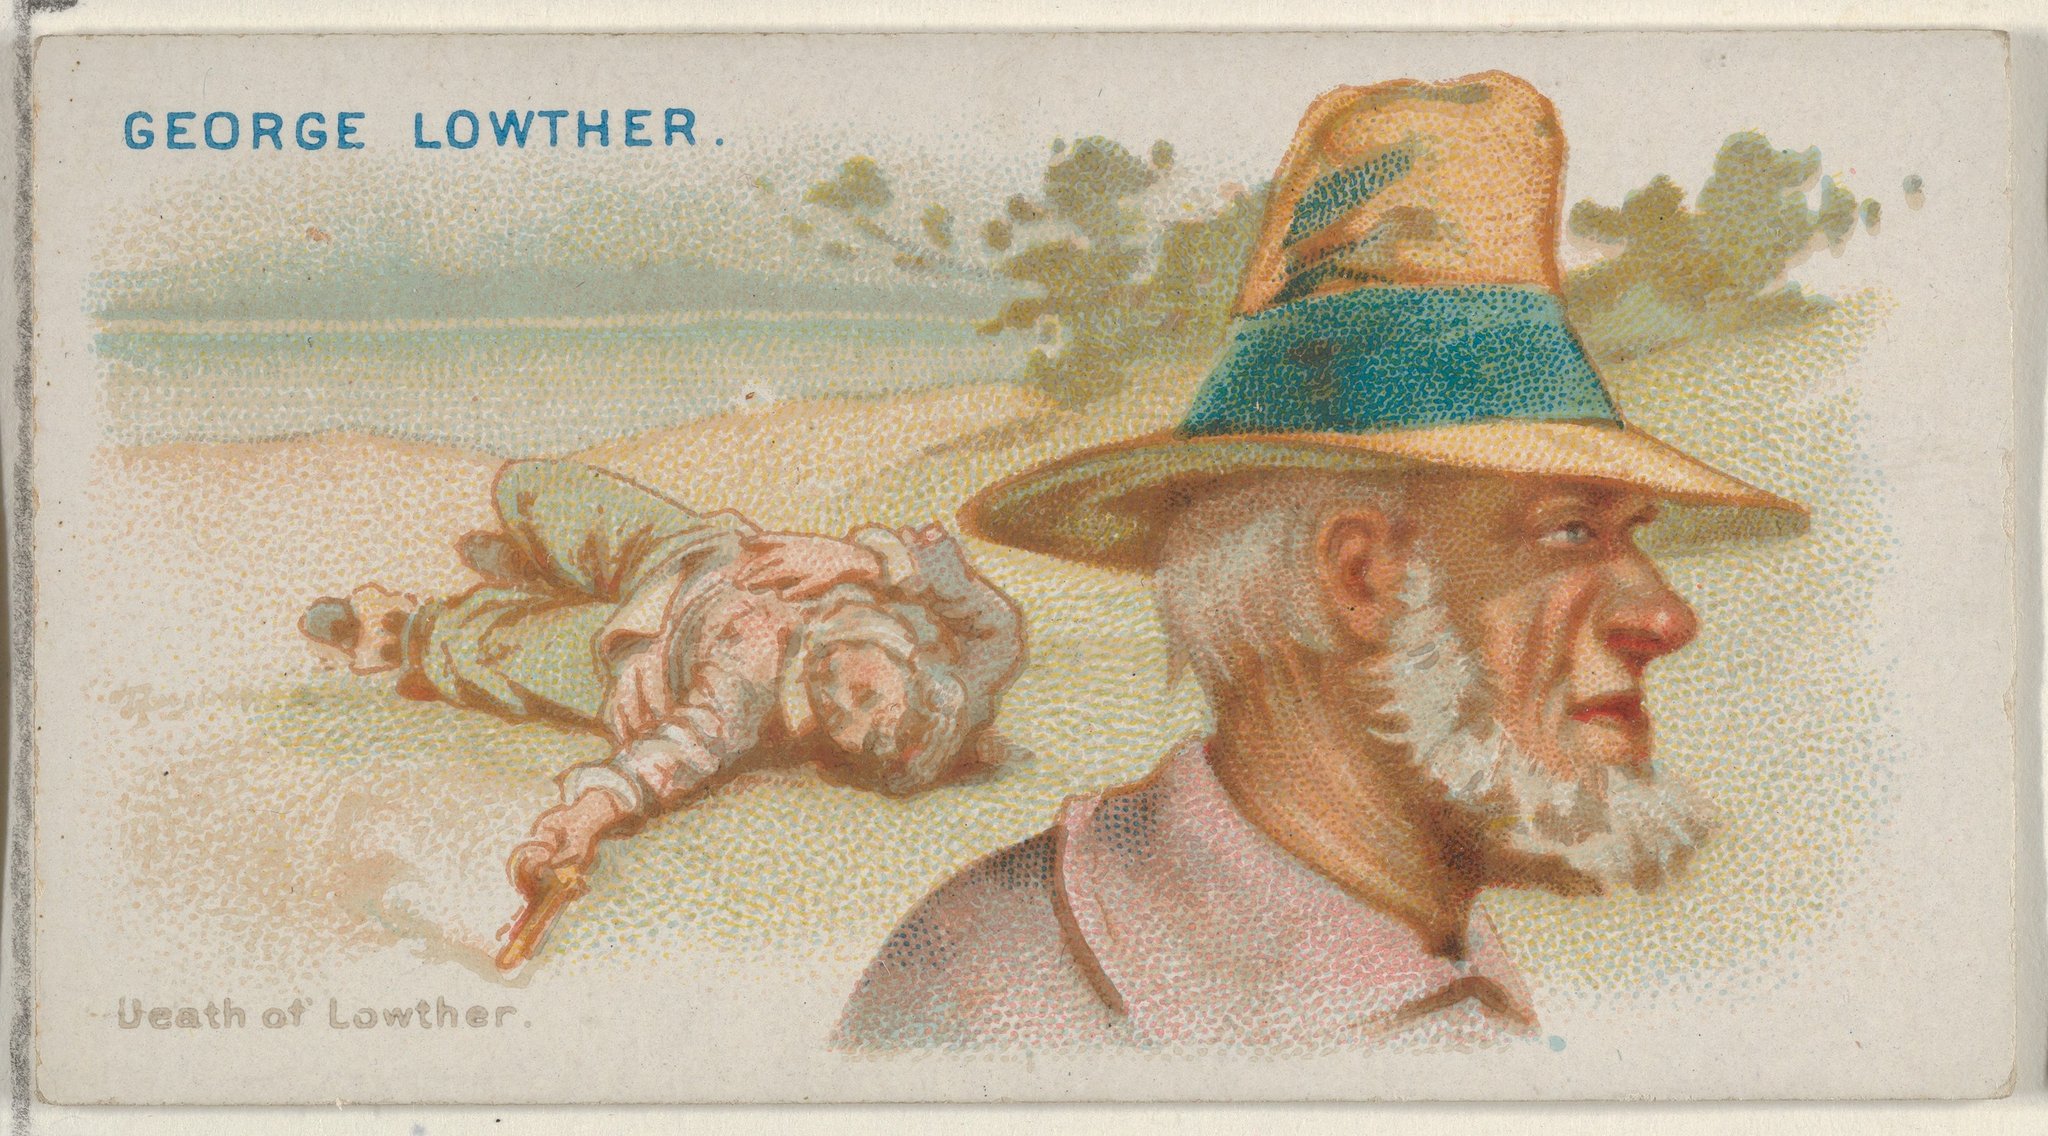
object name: print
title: George Lowther, Death of Lowther, from the Pirates of the Spanish Main series (N19) for Allen & Ginter Cigarettes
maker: allen & ginter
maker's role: publisher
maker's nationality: american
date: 1888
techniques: color lithograph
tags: corpses,men,profiles